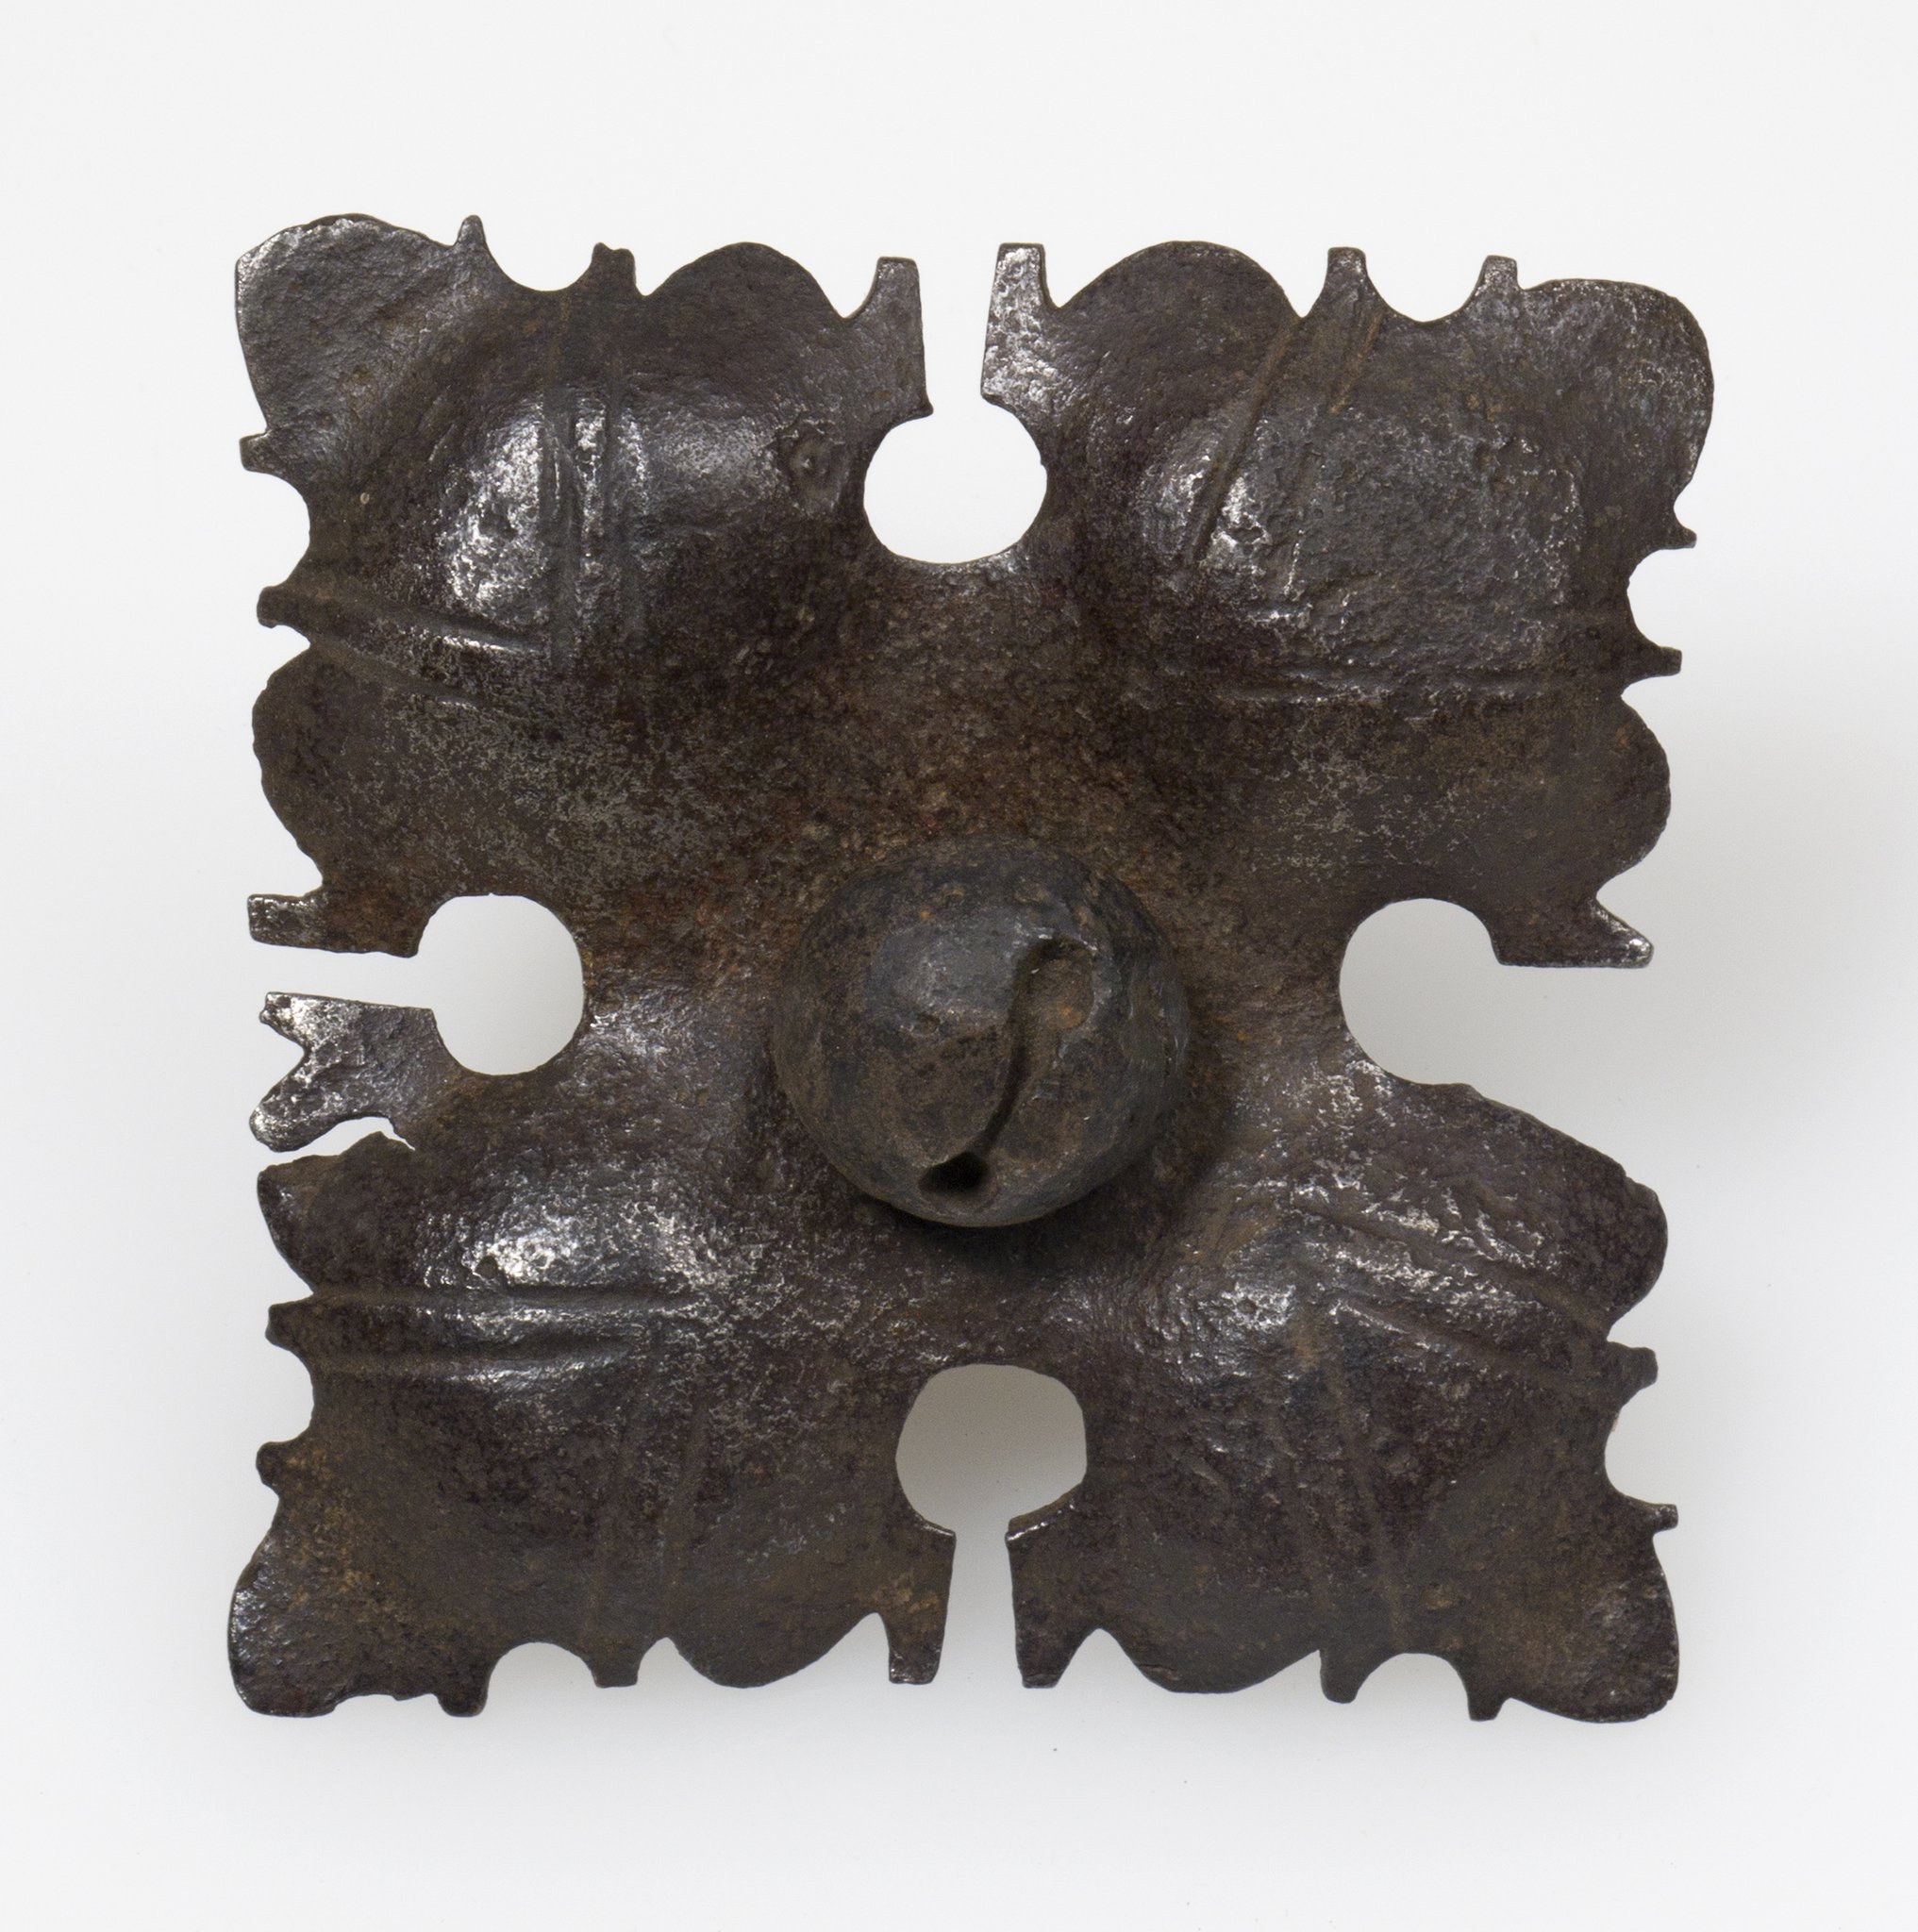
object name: plate and nail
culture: european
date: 1401-1600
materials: iron